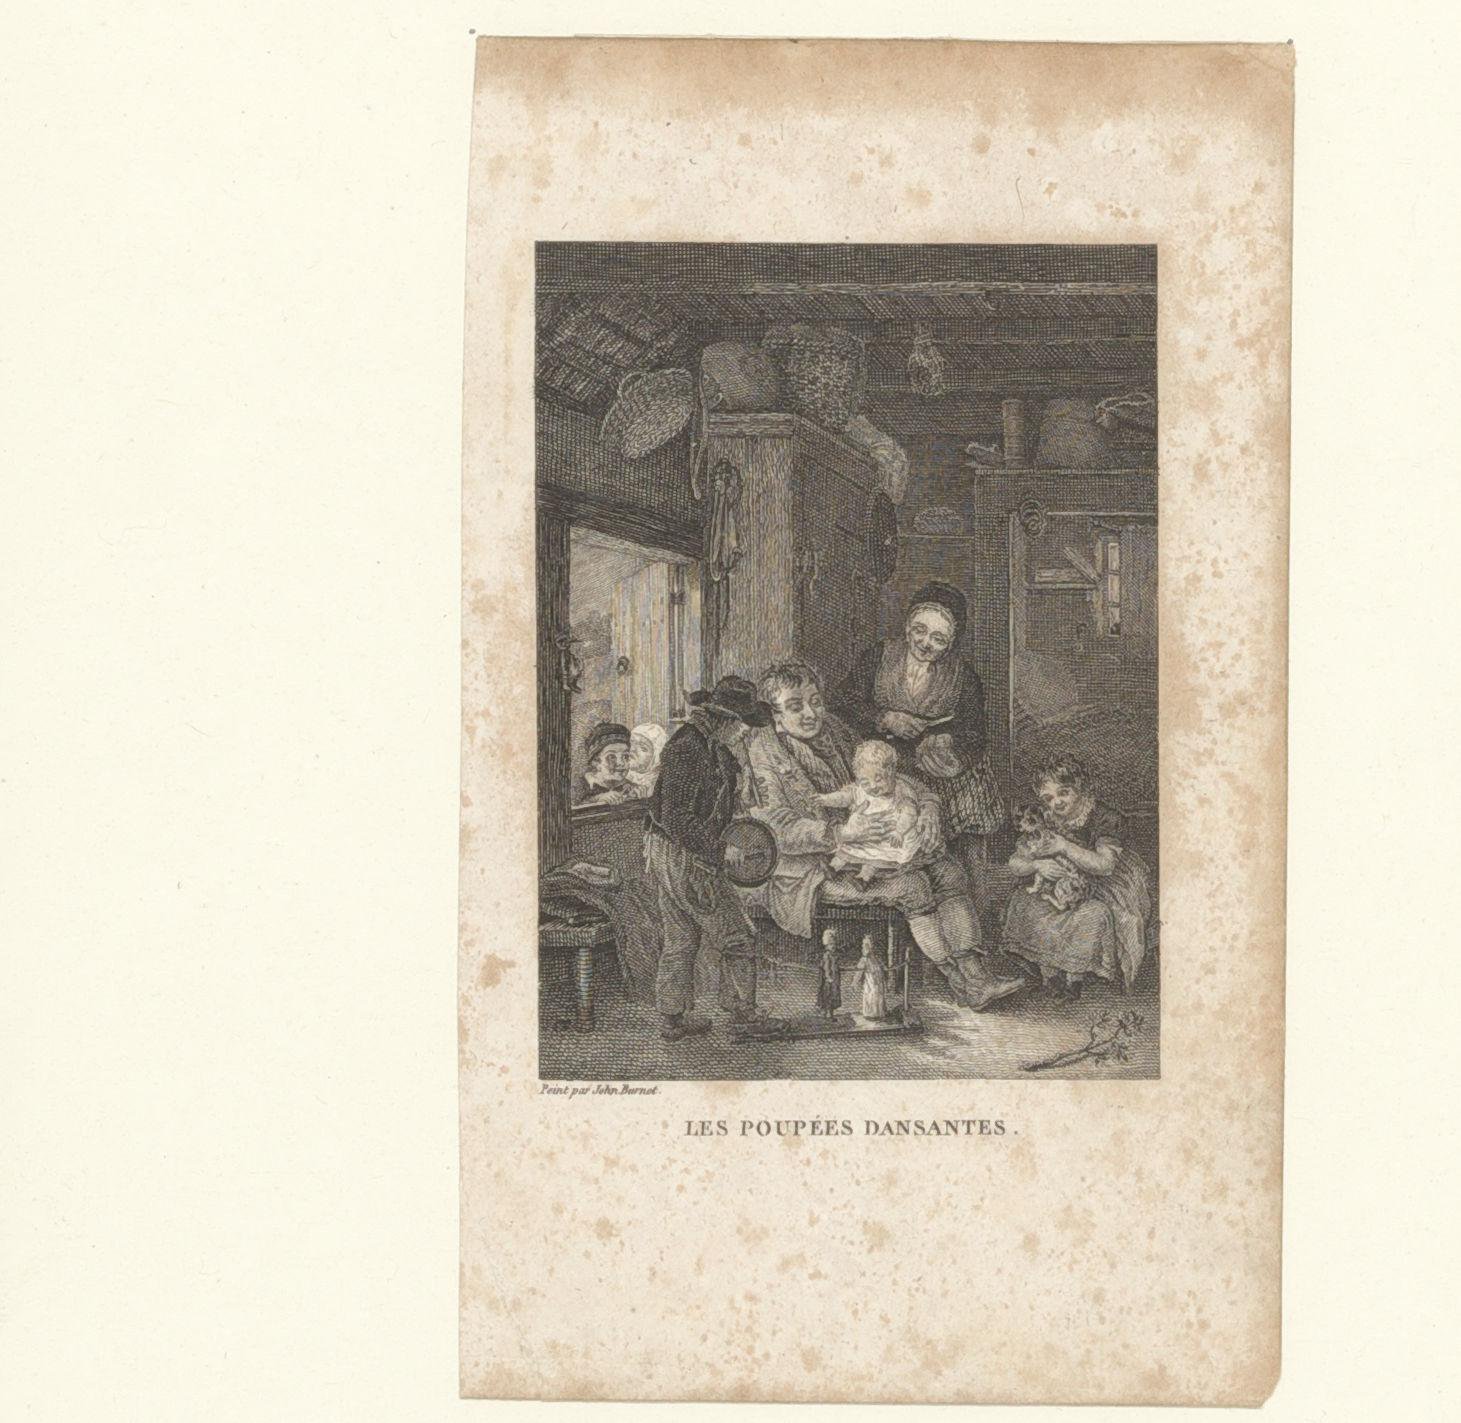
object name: print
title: Gezin kijkt naar twee dansende poppen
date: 1800-1899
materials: paper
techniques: etching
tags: (playing with) dancing dolls, family, relationship, descent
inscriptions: collector's mark: Lugt 1641, stamp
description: Onderwerpsrubrieken binnen de Atlas Zeden en Gewoonten: Zeden en Gewoonten in Engeren Zin, Des menschen beging, midden en einde, Kinderleven – Kinderspel en Kinderprenten.